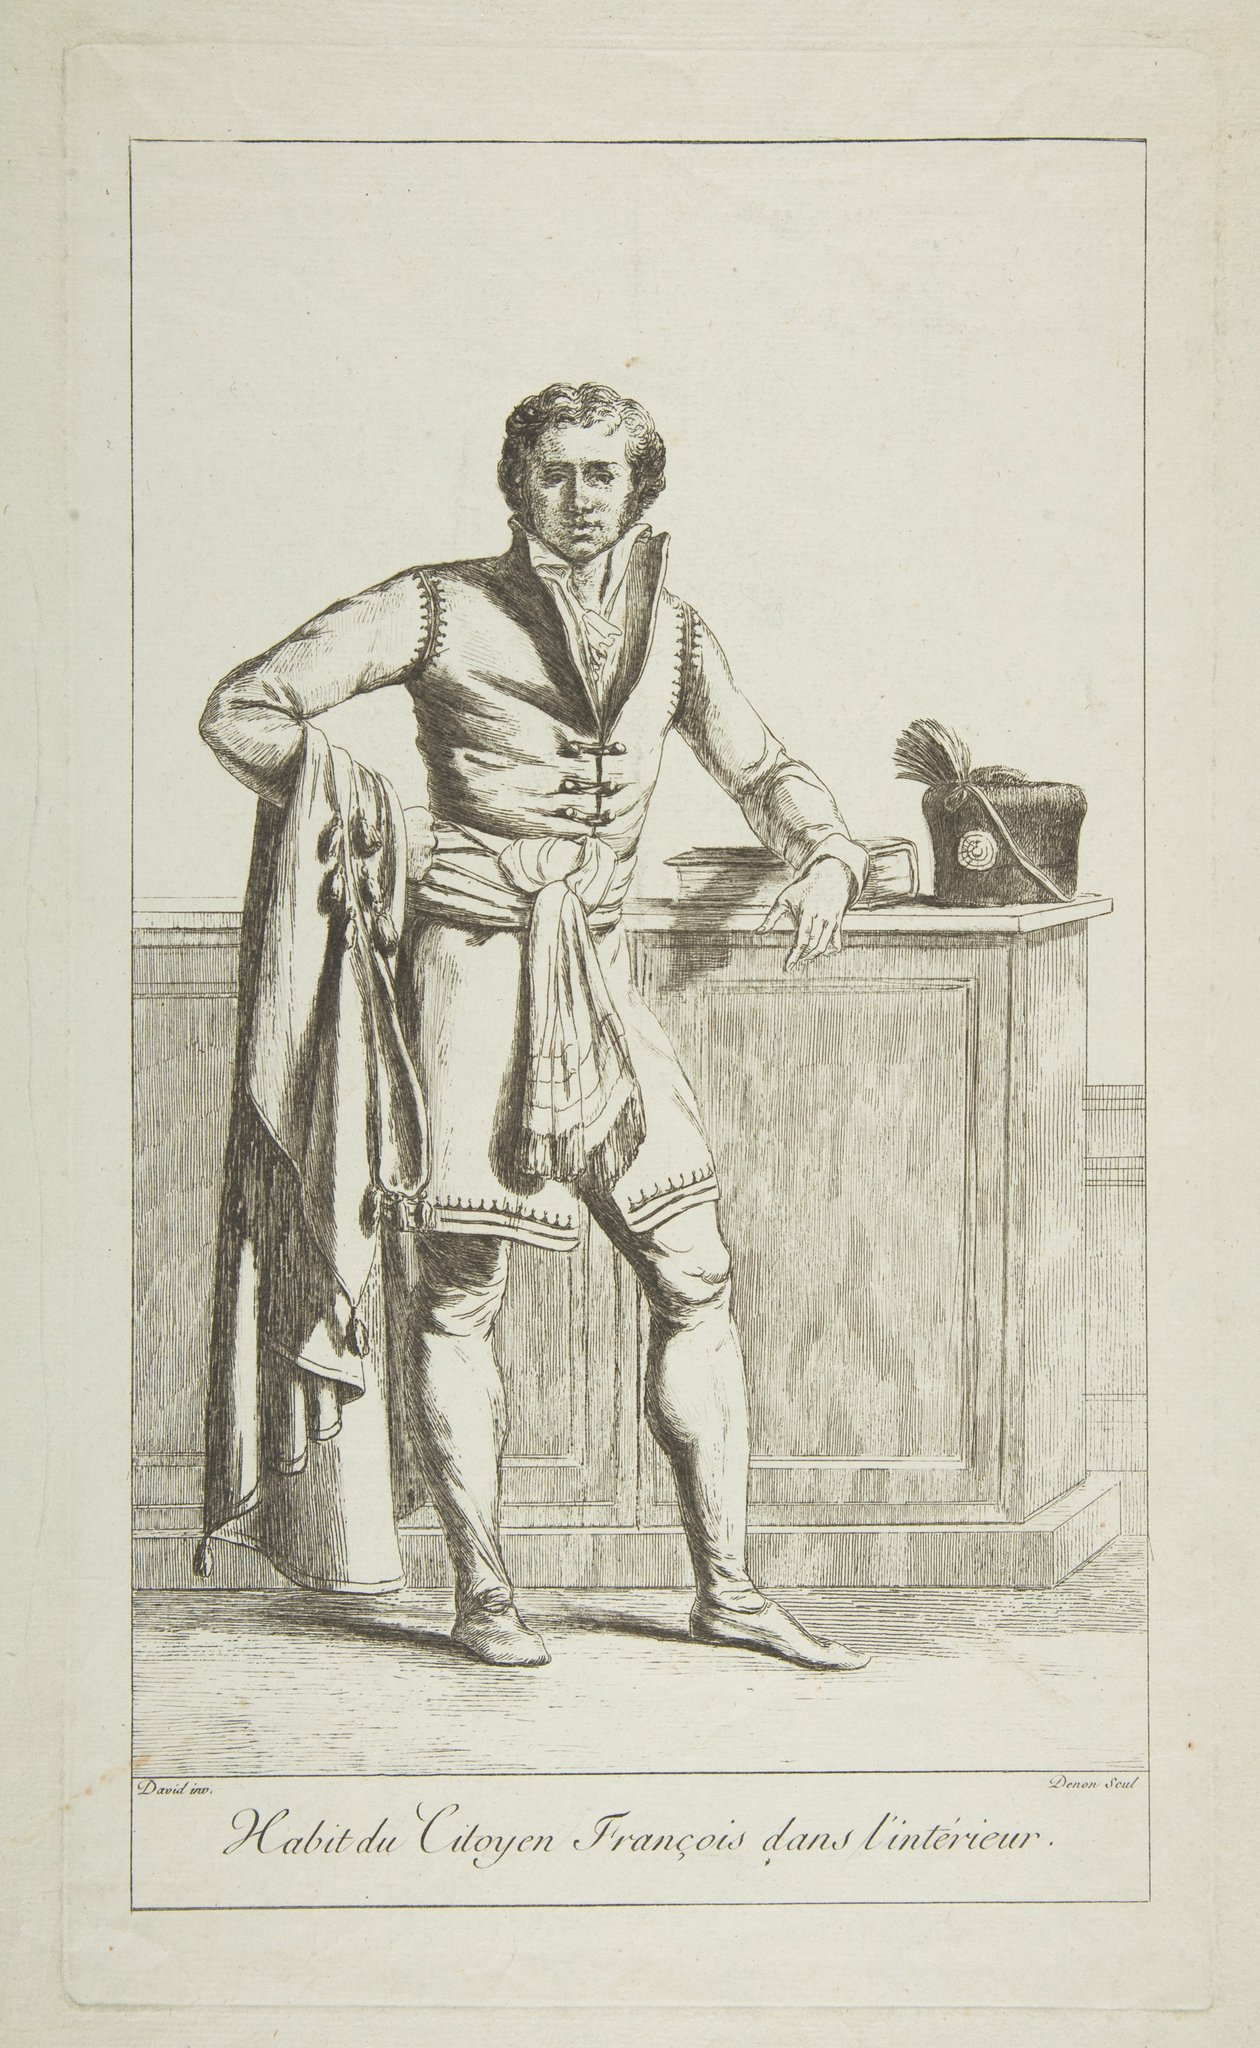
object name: print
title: Inside Attire of the French Citizen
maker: jacques louis david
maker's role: artist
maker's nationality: french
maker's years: 1748-1825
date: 1794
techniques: aquatint, etching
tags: men